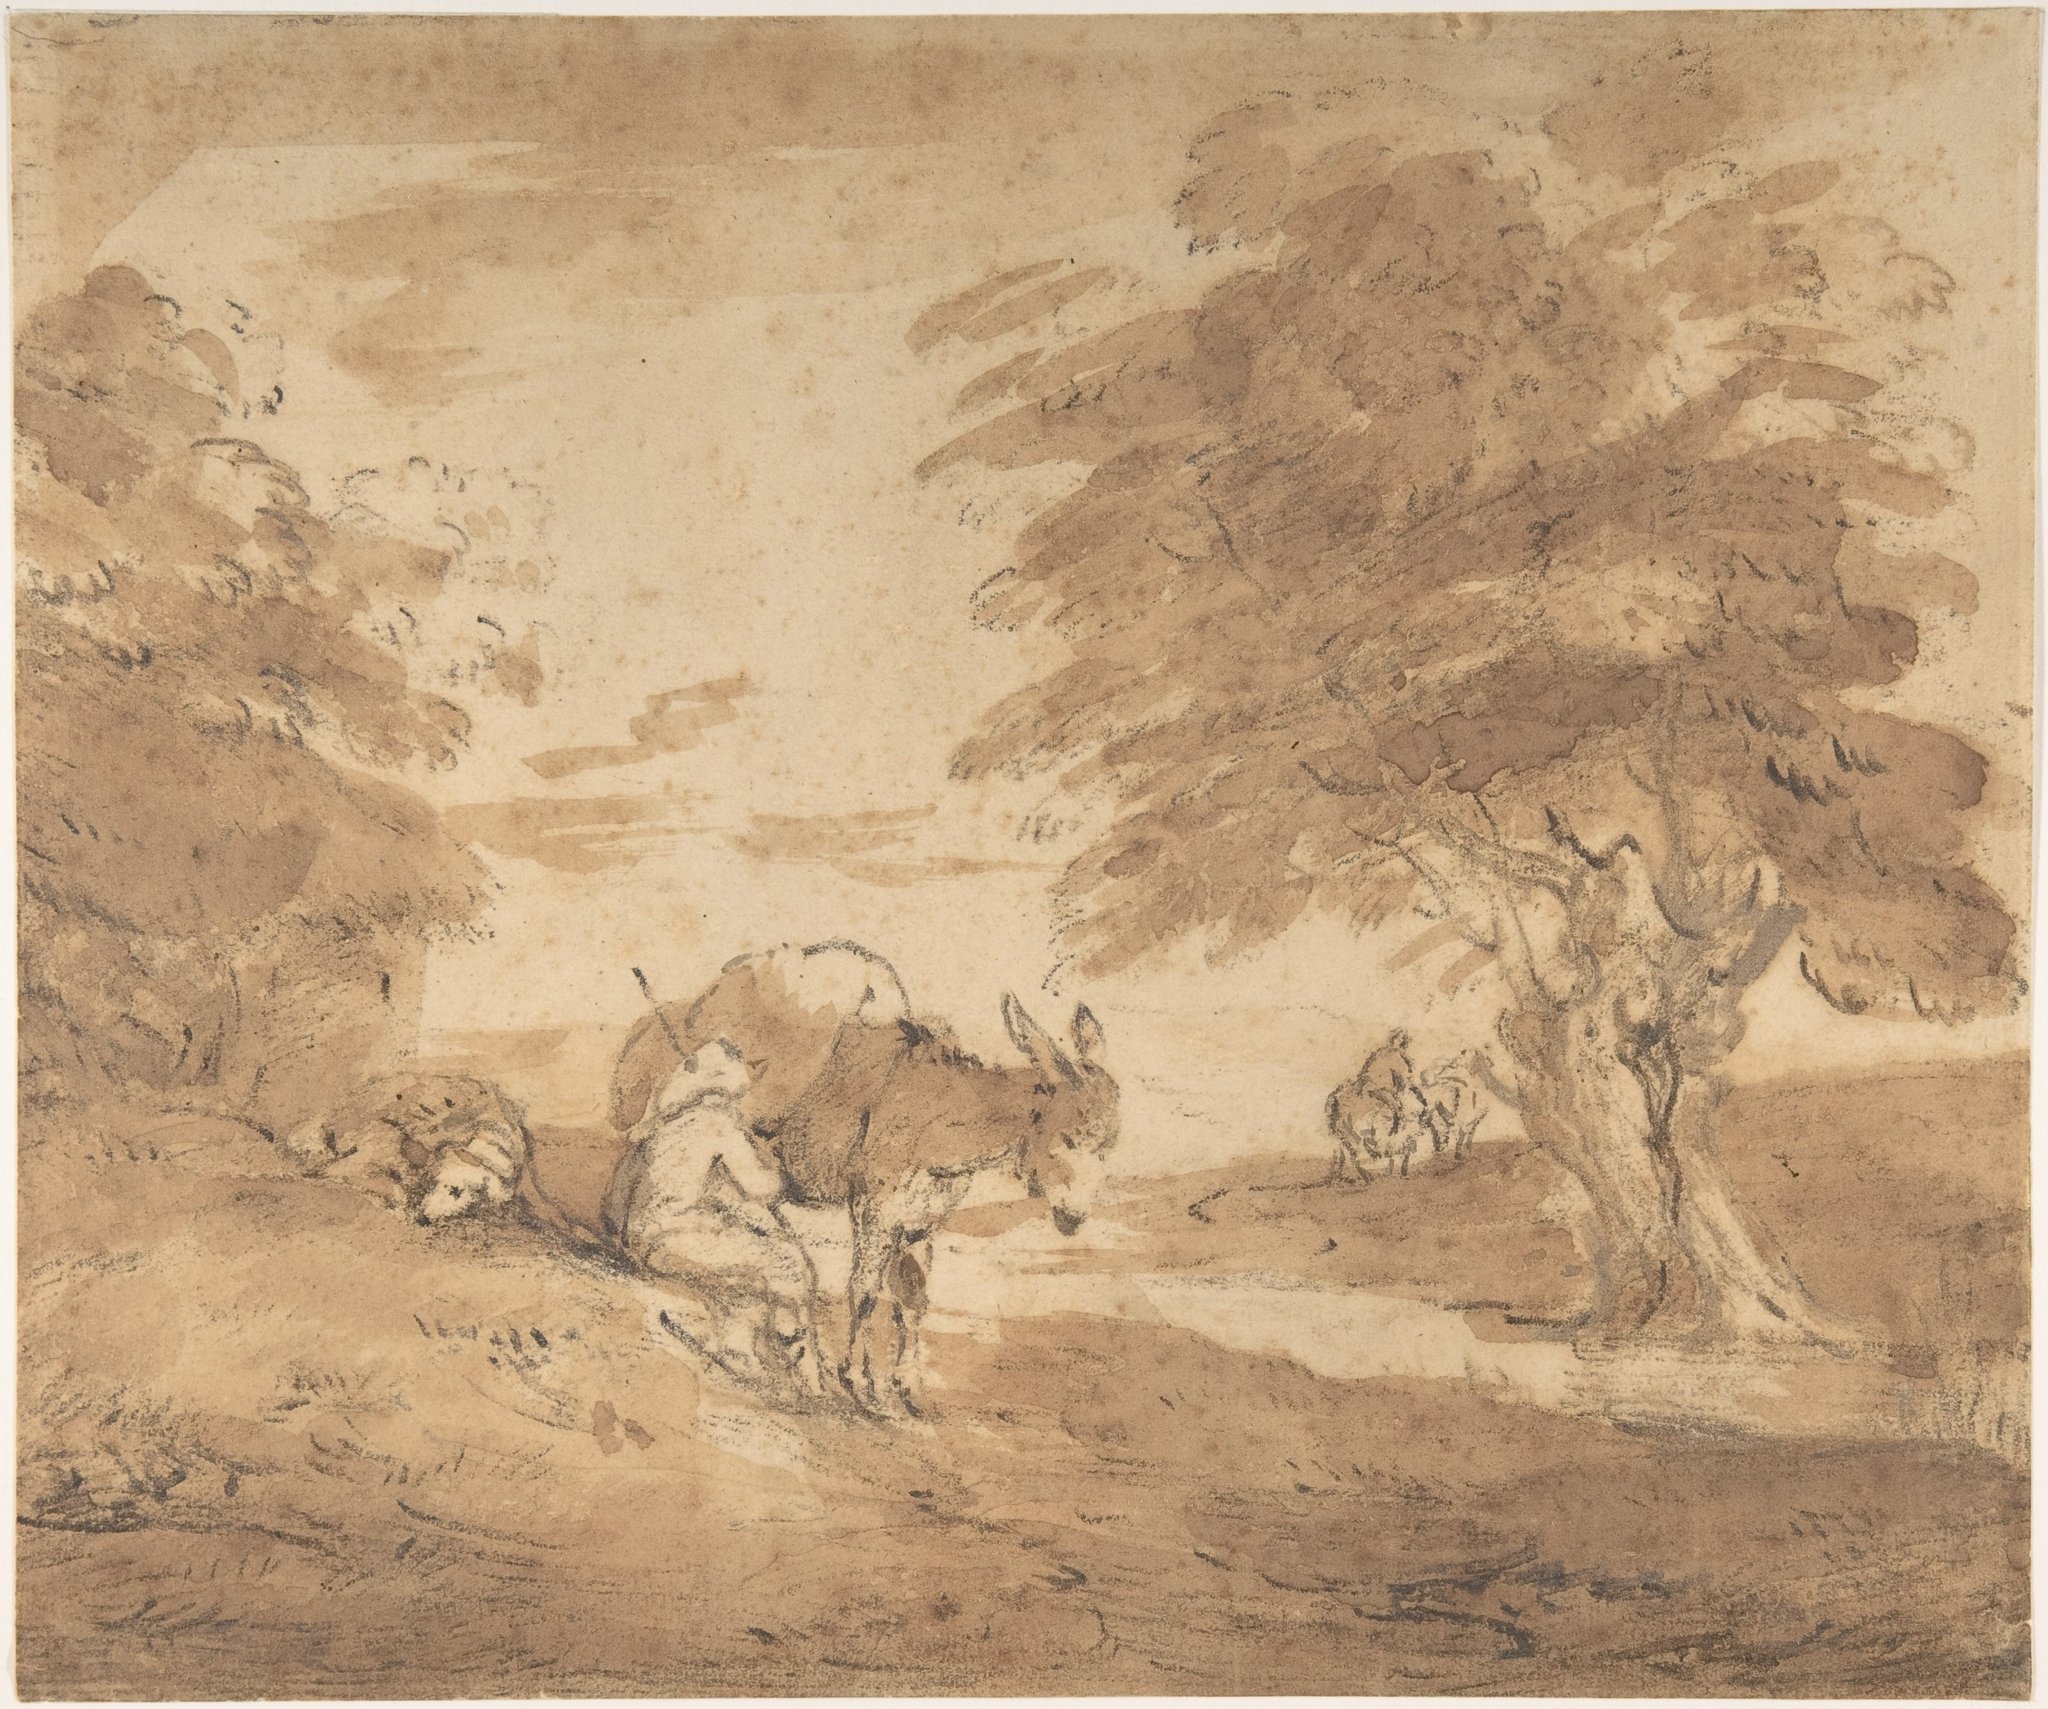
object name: drawing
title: A Rest by the Way (Open Landscape with Figures, Donkey and Horses)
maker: thomas gainsborough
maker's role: artist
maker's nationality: british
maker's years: 1727-1788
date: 1780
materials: chalk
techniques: brush, wash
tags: donkeys,horses,landscapes,trees